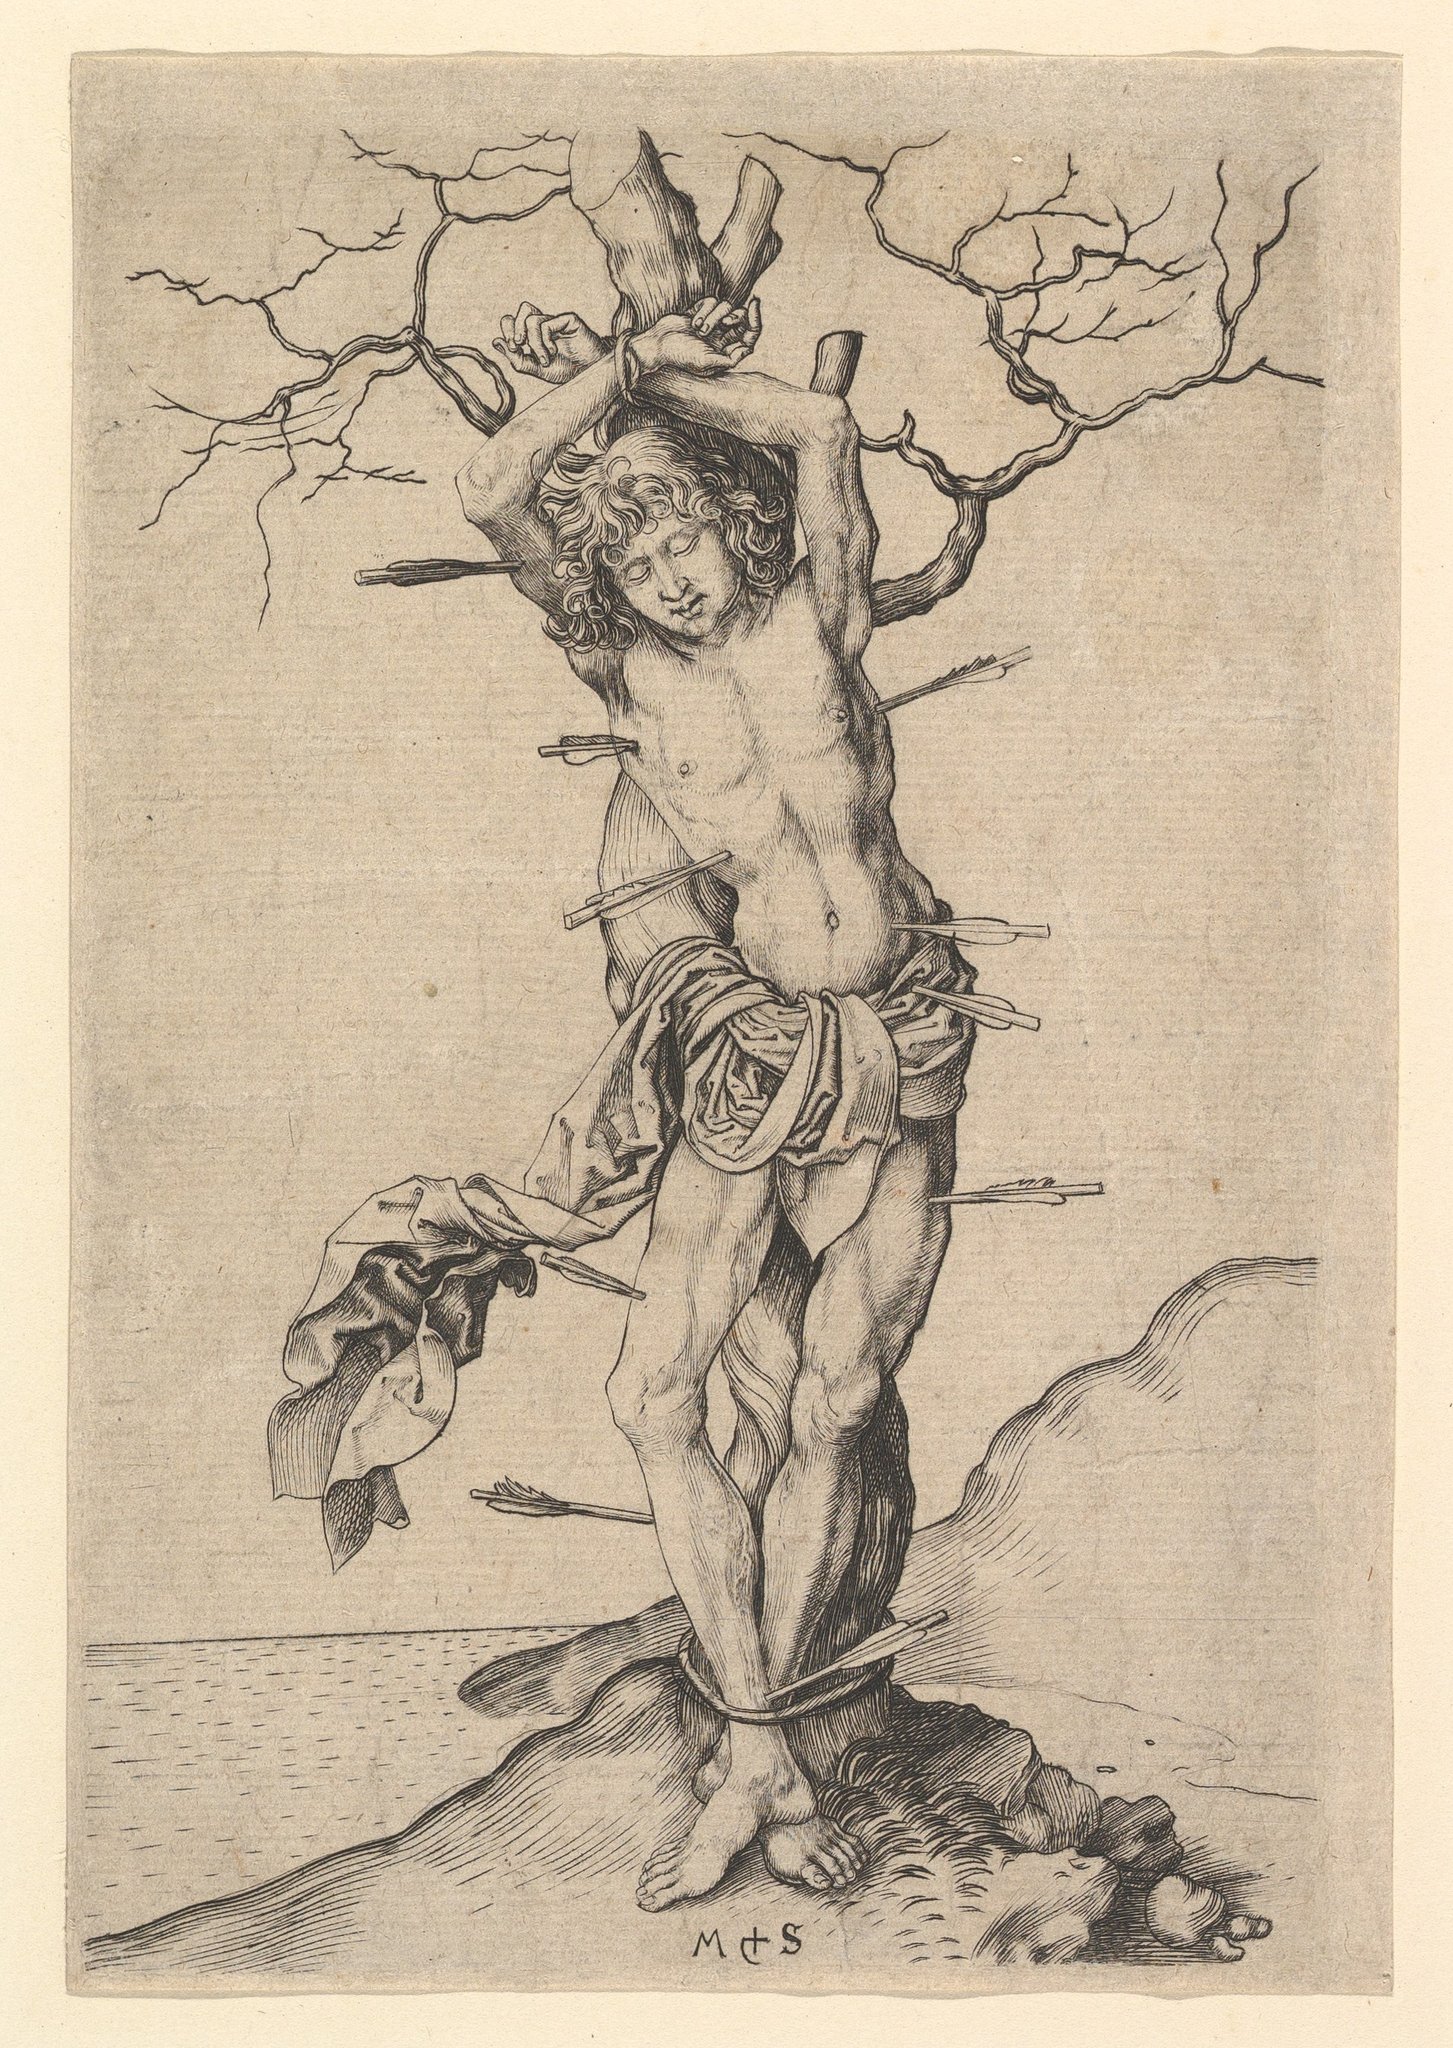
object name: print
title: Saint Sebastian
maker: martin schongauer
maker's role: artist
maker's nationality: german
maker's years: 1430-1491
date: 1470-1491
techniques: engraving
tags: arrows,men,trees,saints